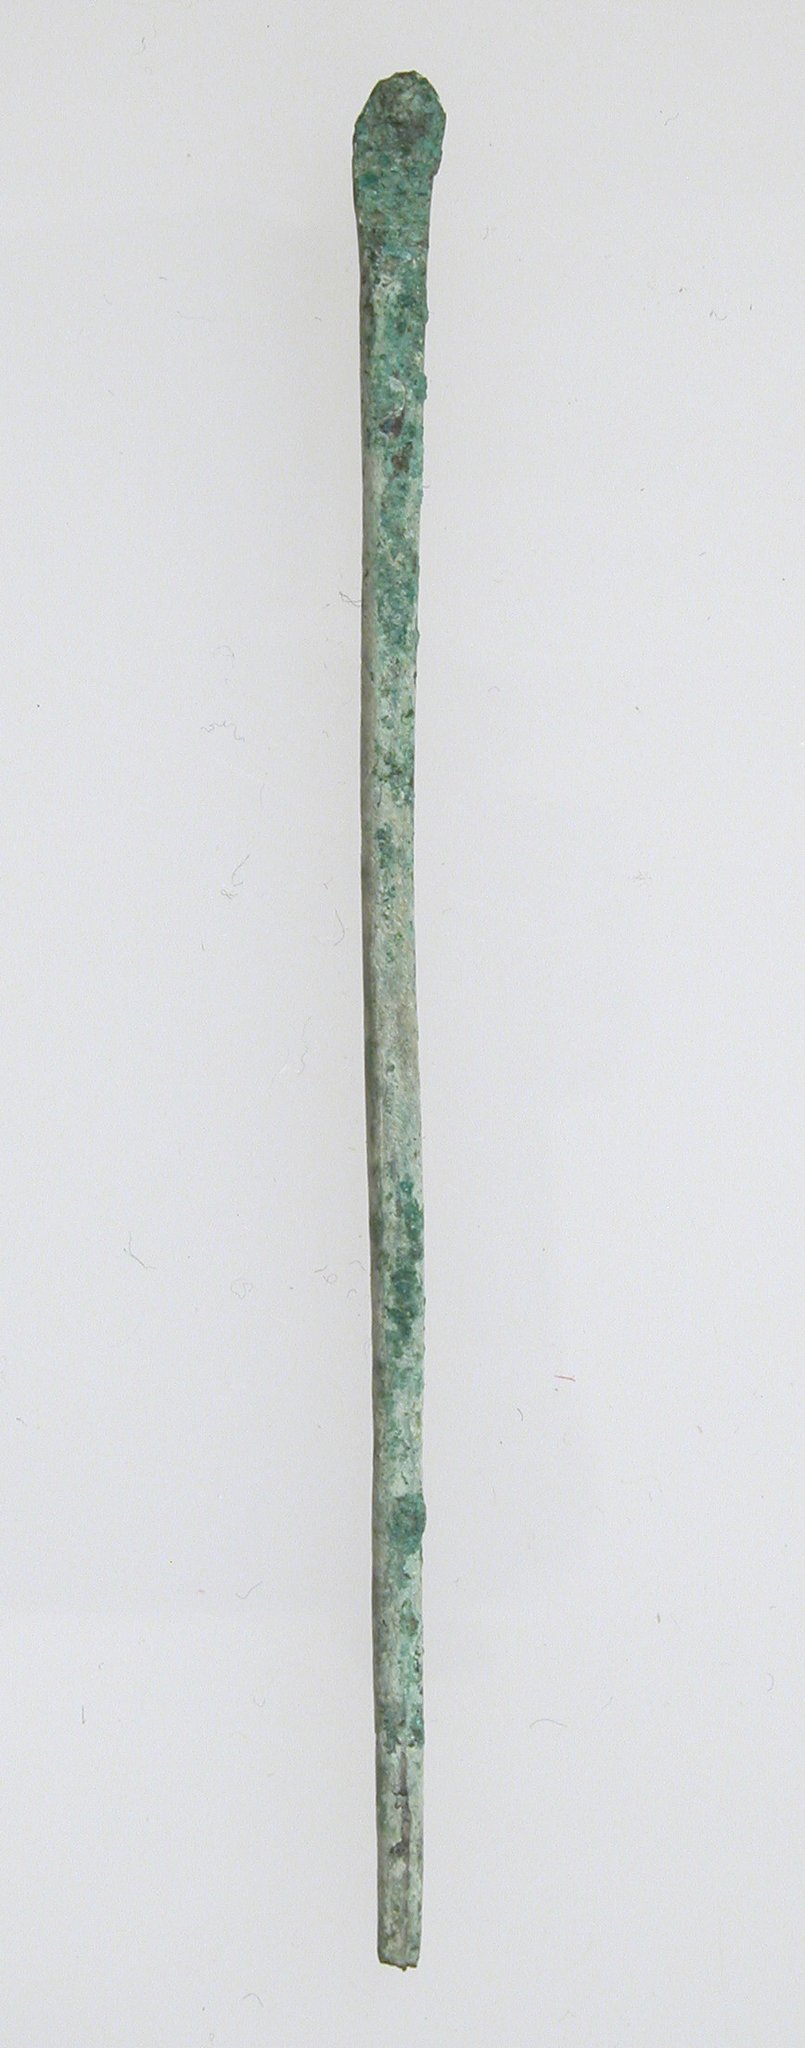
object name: hairpin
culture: roman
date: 1-400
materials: copper alloy